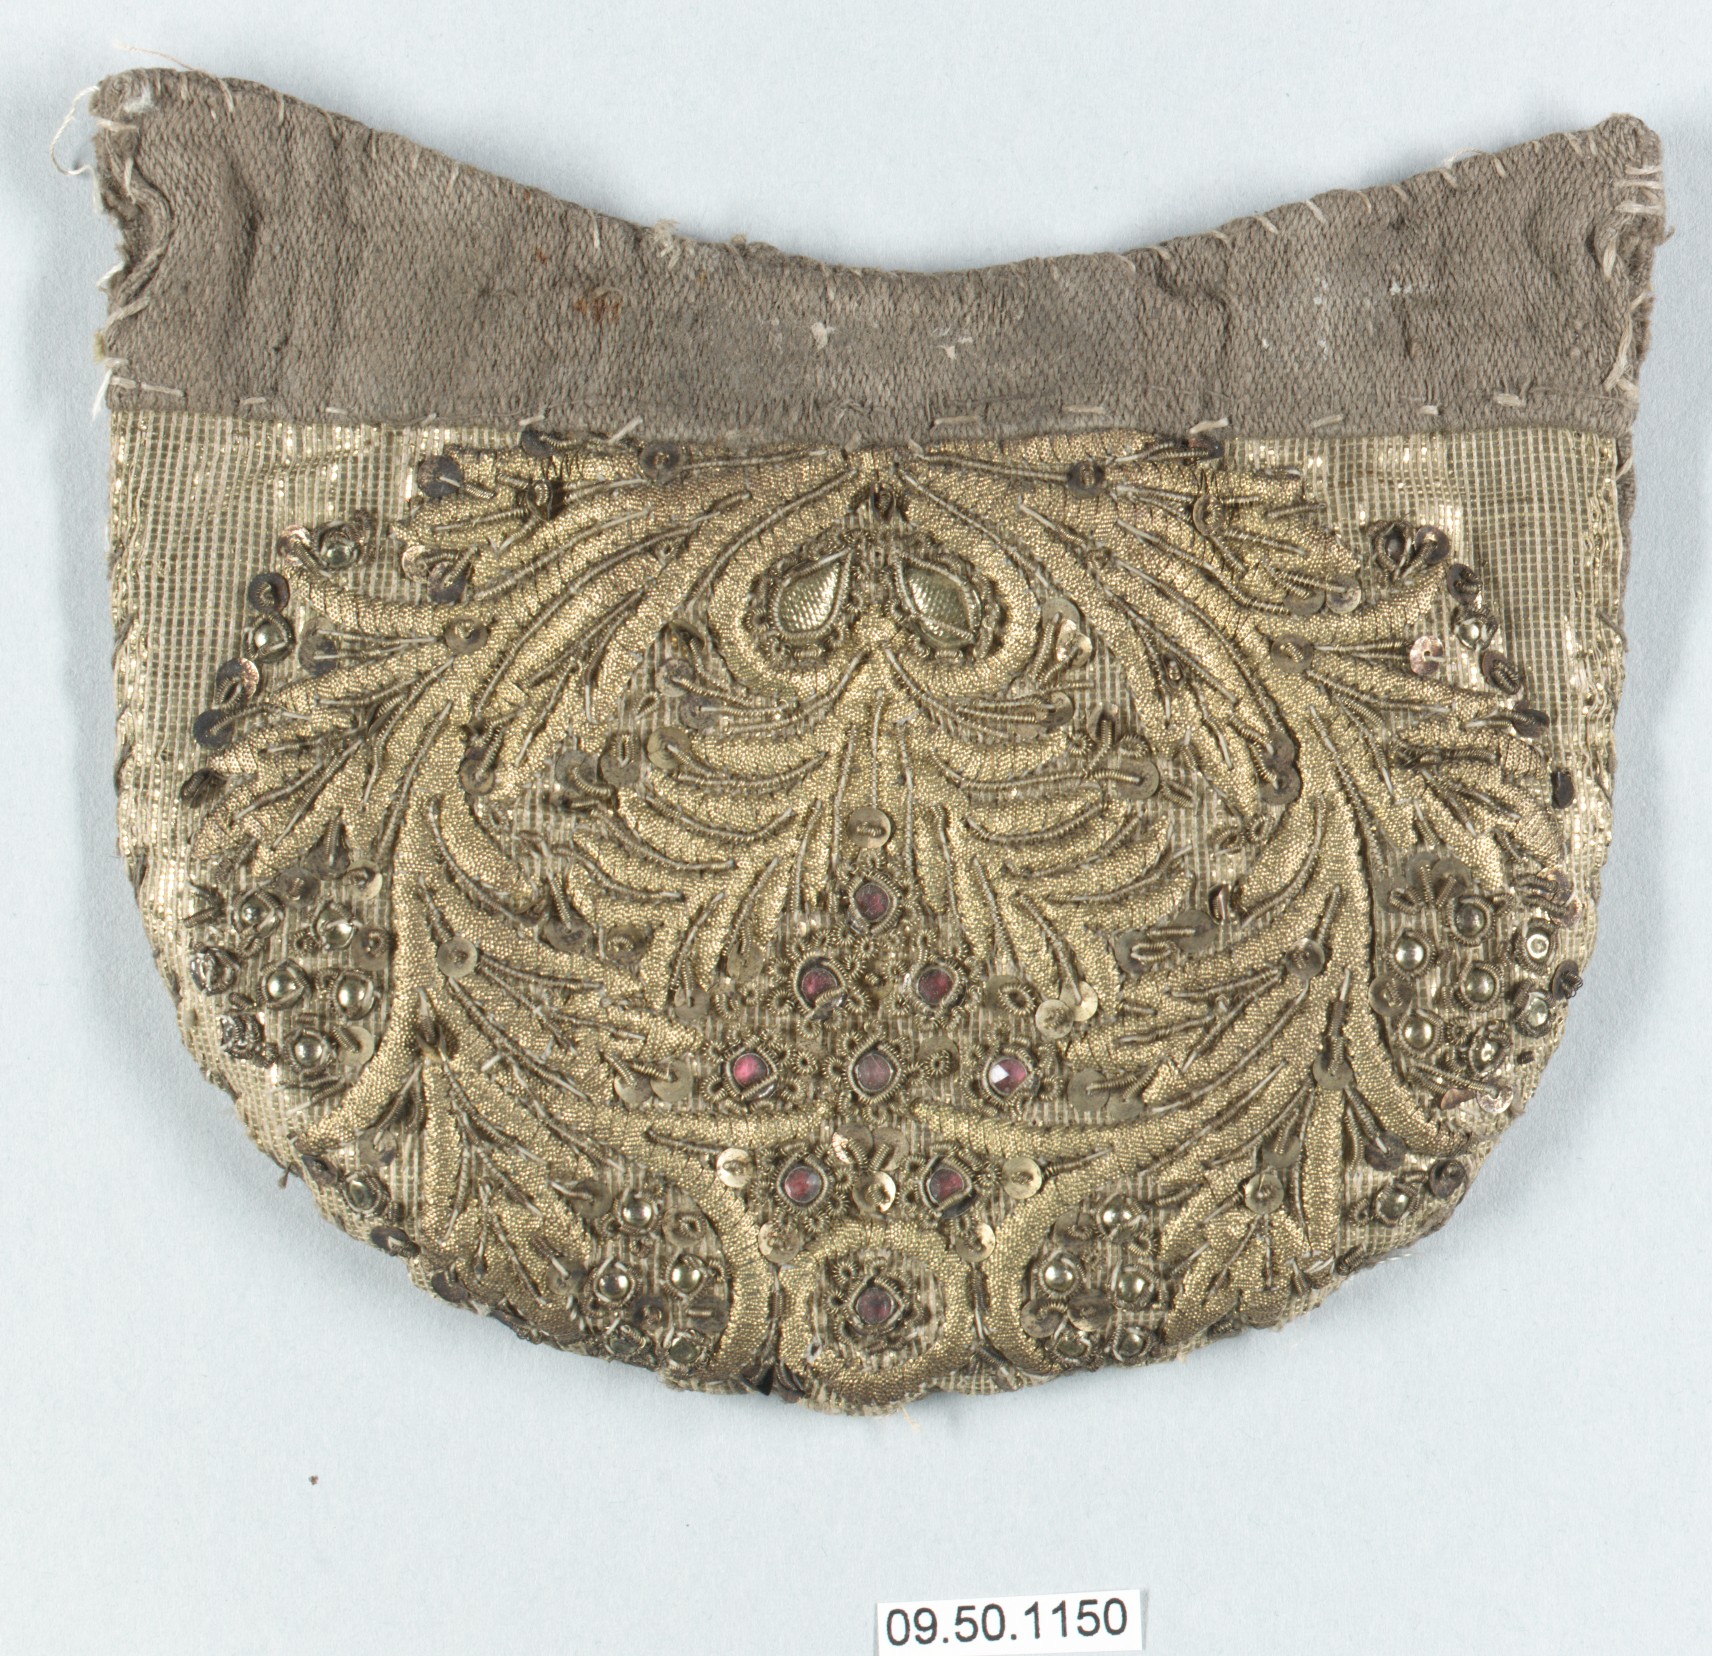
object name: cap crown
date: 1801-1900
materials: metal thread